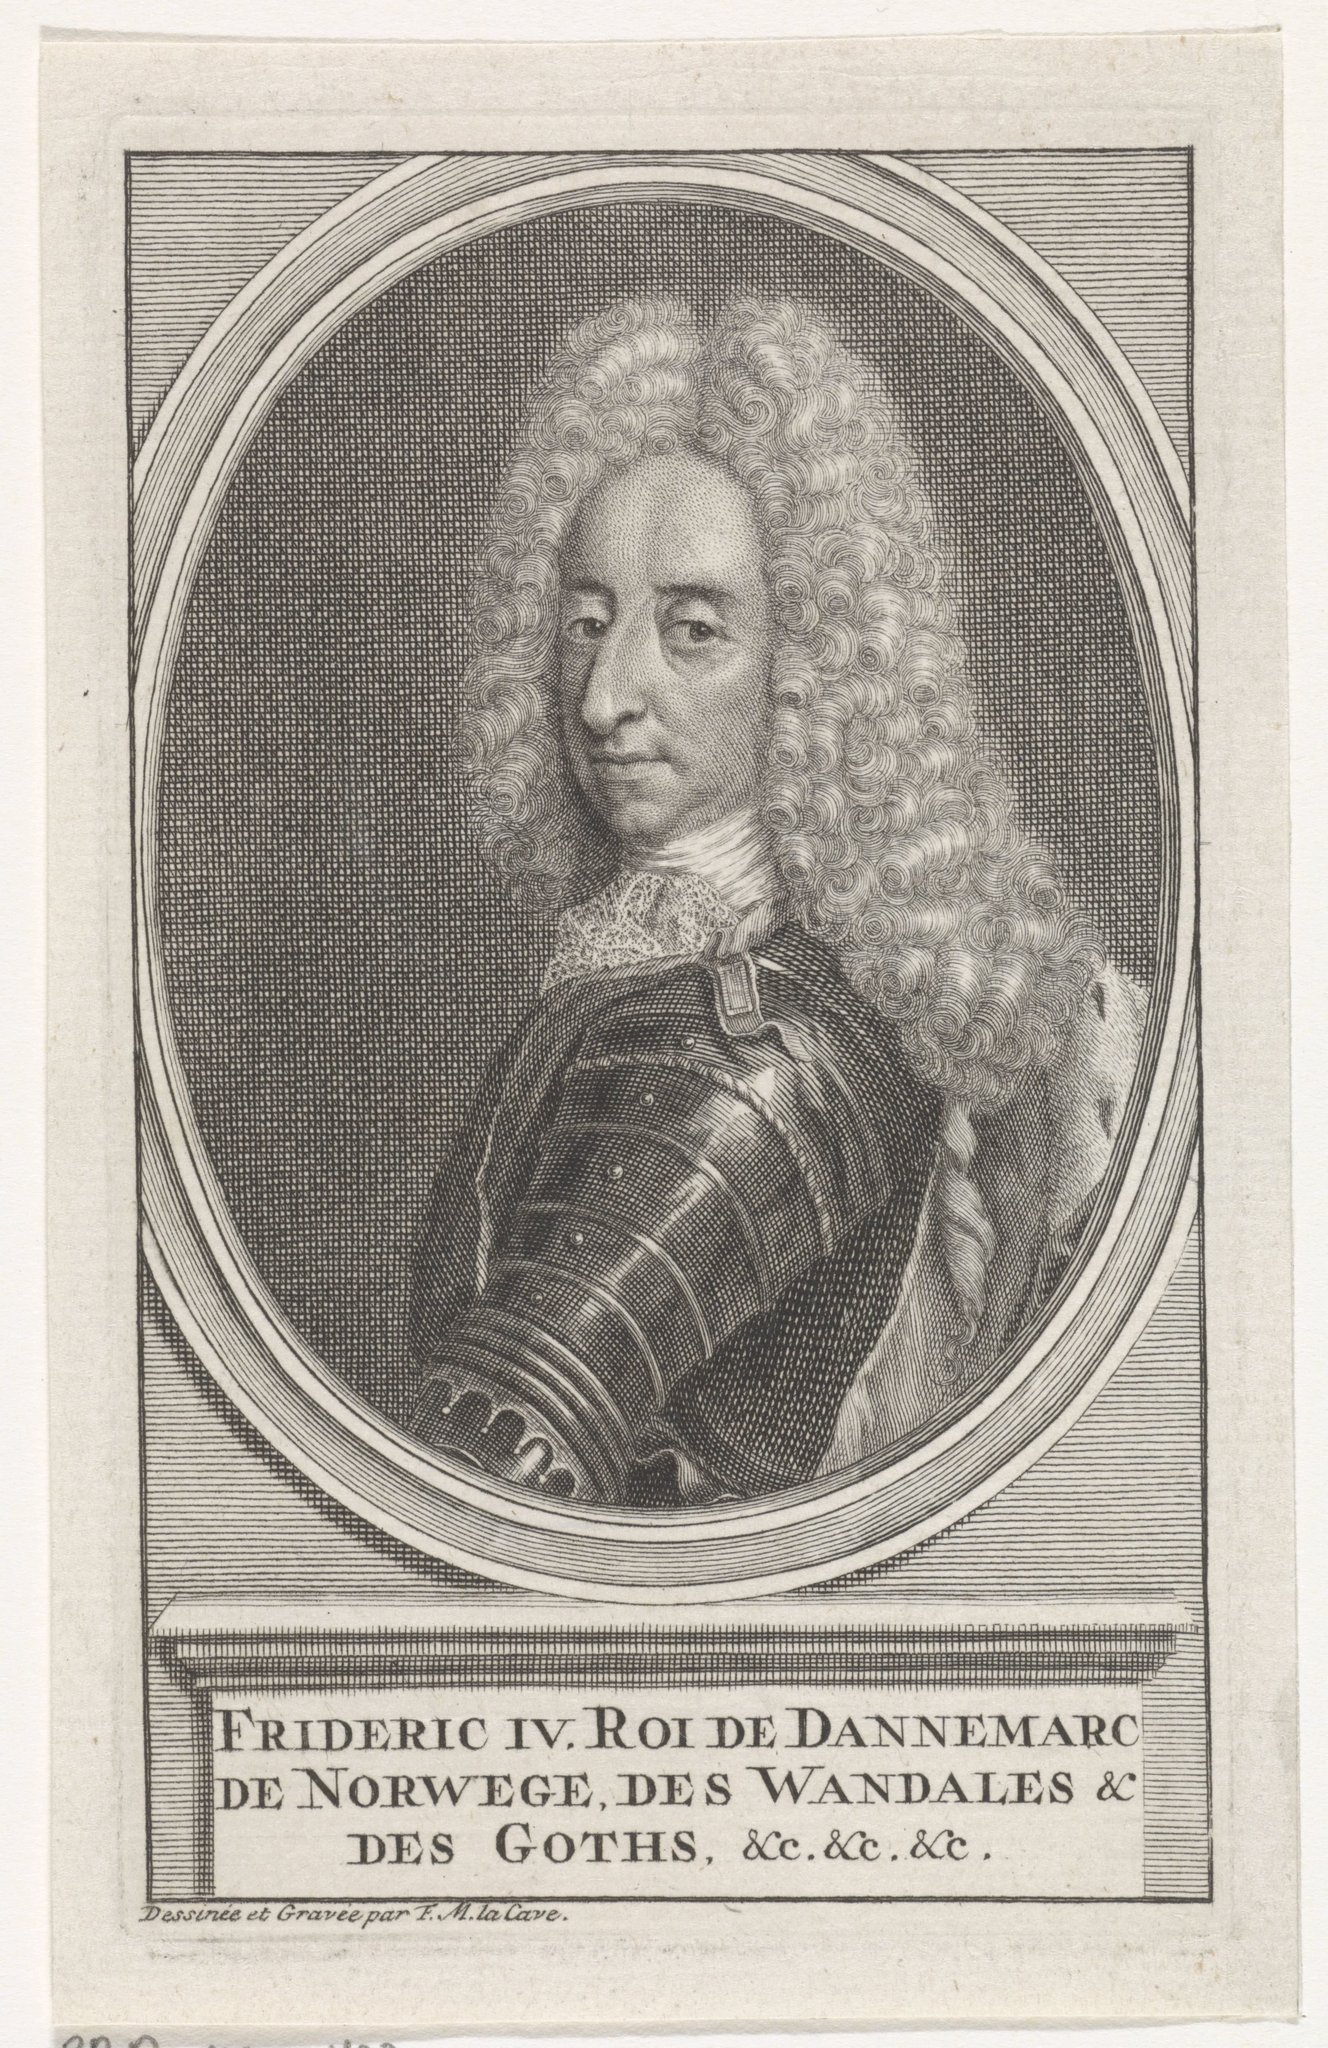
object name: print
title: Portret van koning Frederik IV van Denemarken en Noorwegen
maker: françois morellon la cave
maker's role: draughtsman, print maker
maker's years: 1696-1768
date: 1706-1768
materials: paper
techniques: engraving, etching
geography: amsterdam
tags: copenhagen (city), frederik iv (koning van denemarken en noorwegen)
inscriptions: collector's mark: Lugt 2228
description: Portret van Frederik IV, koning van Denemarken en Noorwegen, gekleed in harnas.